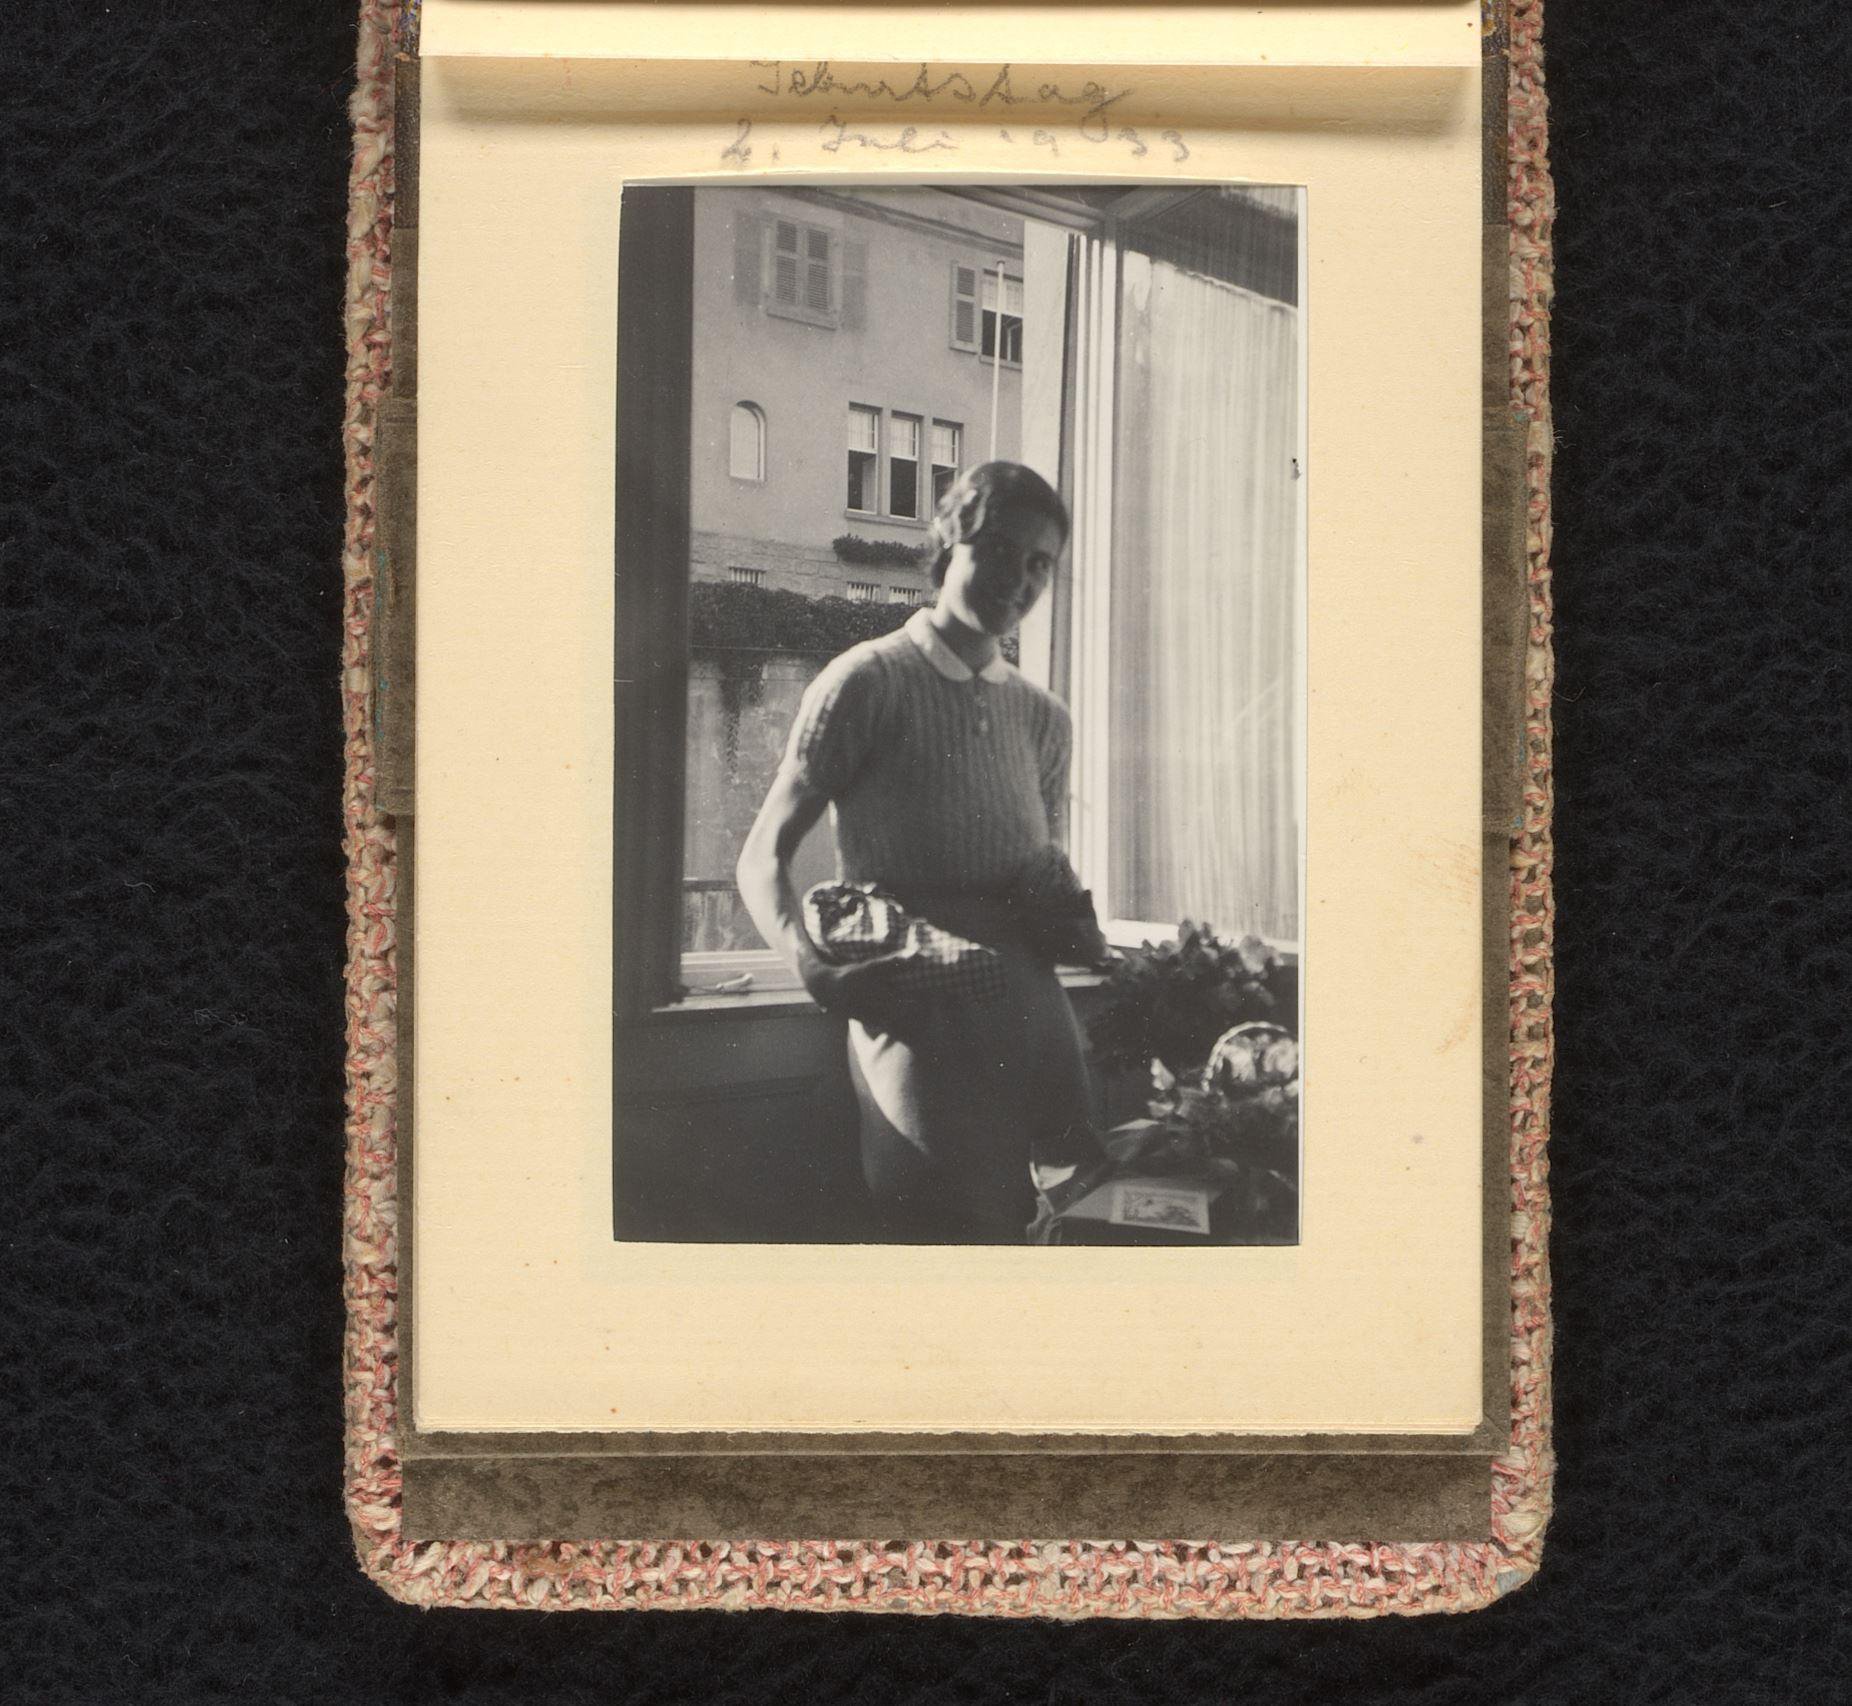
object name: album leaf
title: Het kindermeisje van de familie Wachenheimer op haar verjaardag, 2 juli 1933, Stuttgart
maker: else wachenheimer-moos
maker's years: 1895-1944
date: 1933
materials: paper, photographic support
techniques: gelatin silver print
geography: stuttgart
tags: birthday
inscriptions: inscription: ‘Geburtstag 2. Juli 1933’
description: Albumblad bevat een foto van het kindermeisje van de familie Wachenheimer. Onderdeel van het fotoalbum Hamburg zomer 1933.